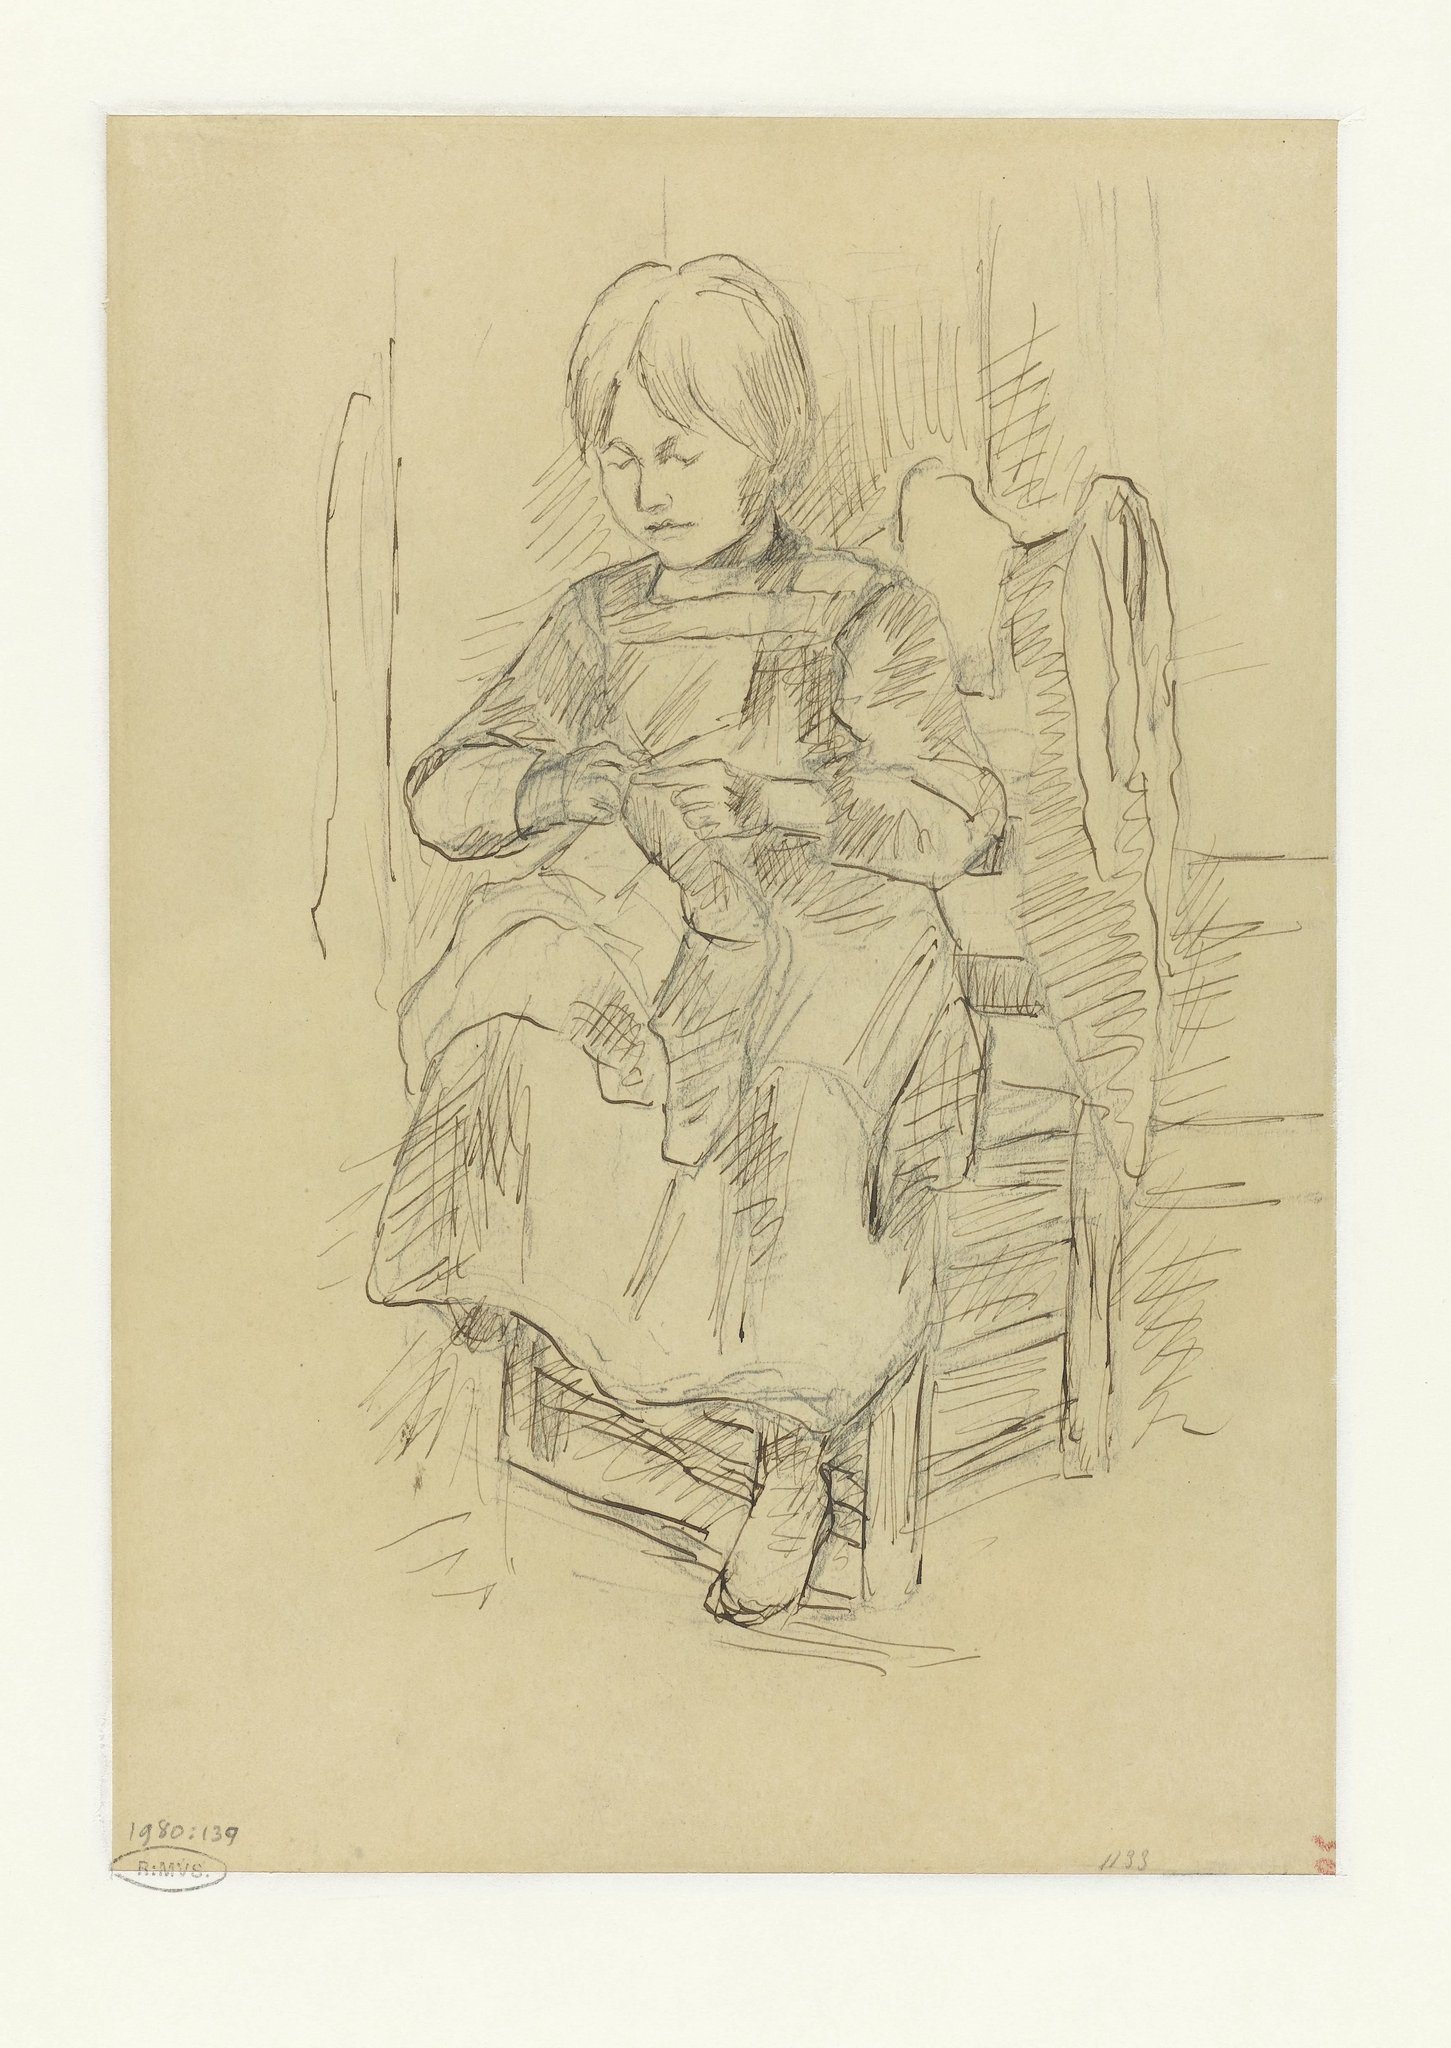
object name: drawing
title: Breiend meisje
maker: jozef israëls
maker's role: draughtsman, painter, print maker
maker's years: 1824-1911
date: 1834-1911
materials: ink, paper, pencil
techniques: pen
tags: (other forms of) needlework, e.g.: crocheting, knitting, embroidering